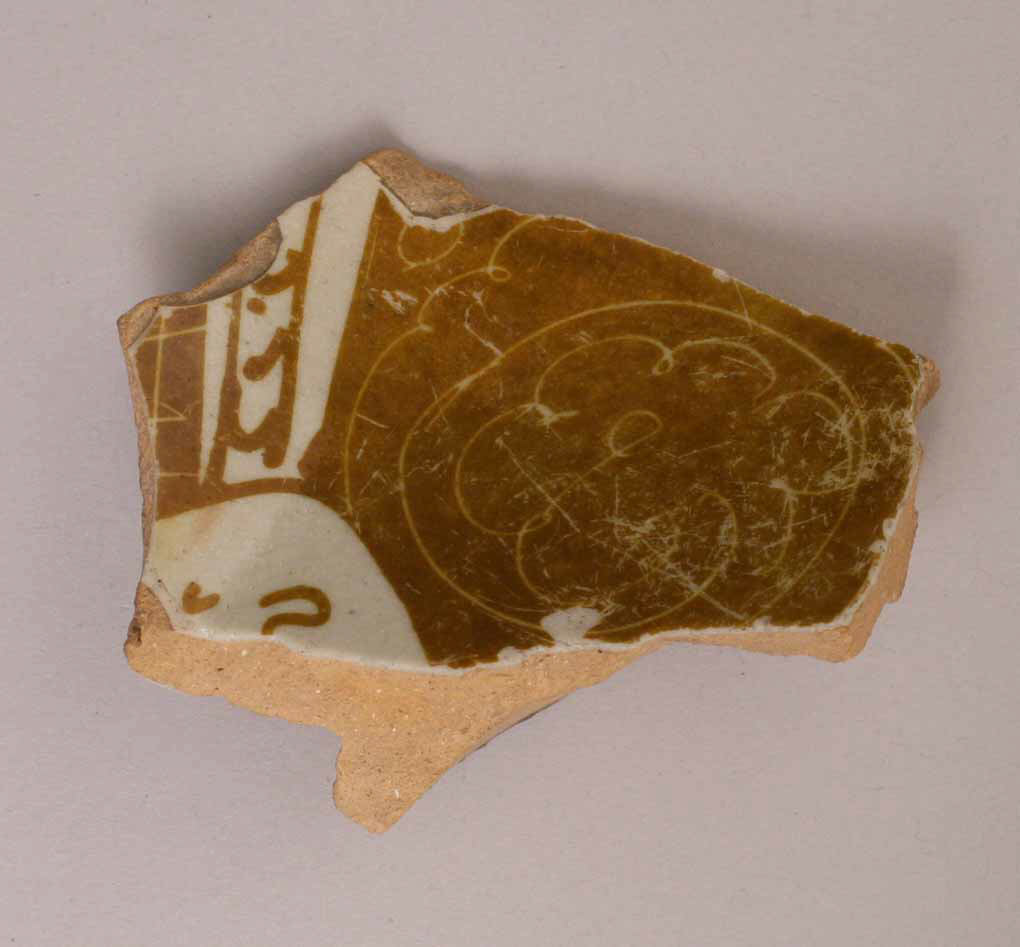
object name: ceramic fragment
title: Fragment of a Dish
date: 1001-1200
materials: earthenware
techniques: luster painting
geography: egypt